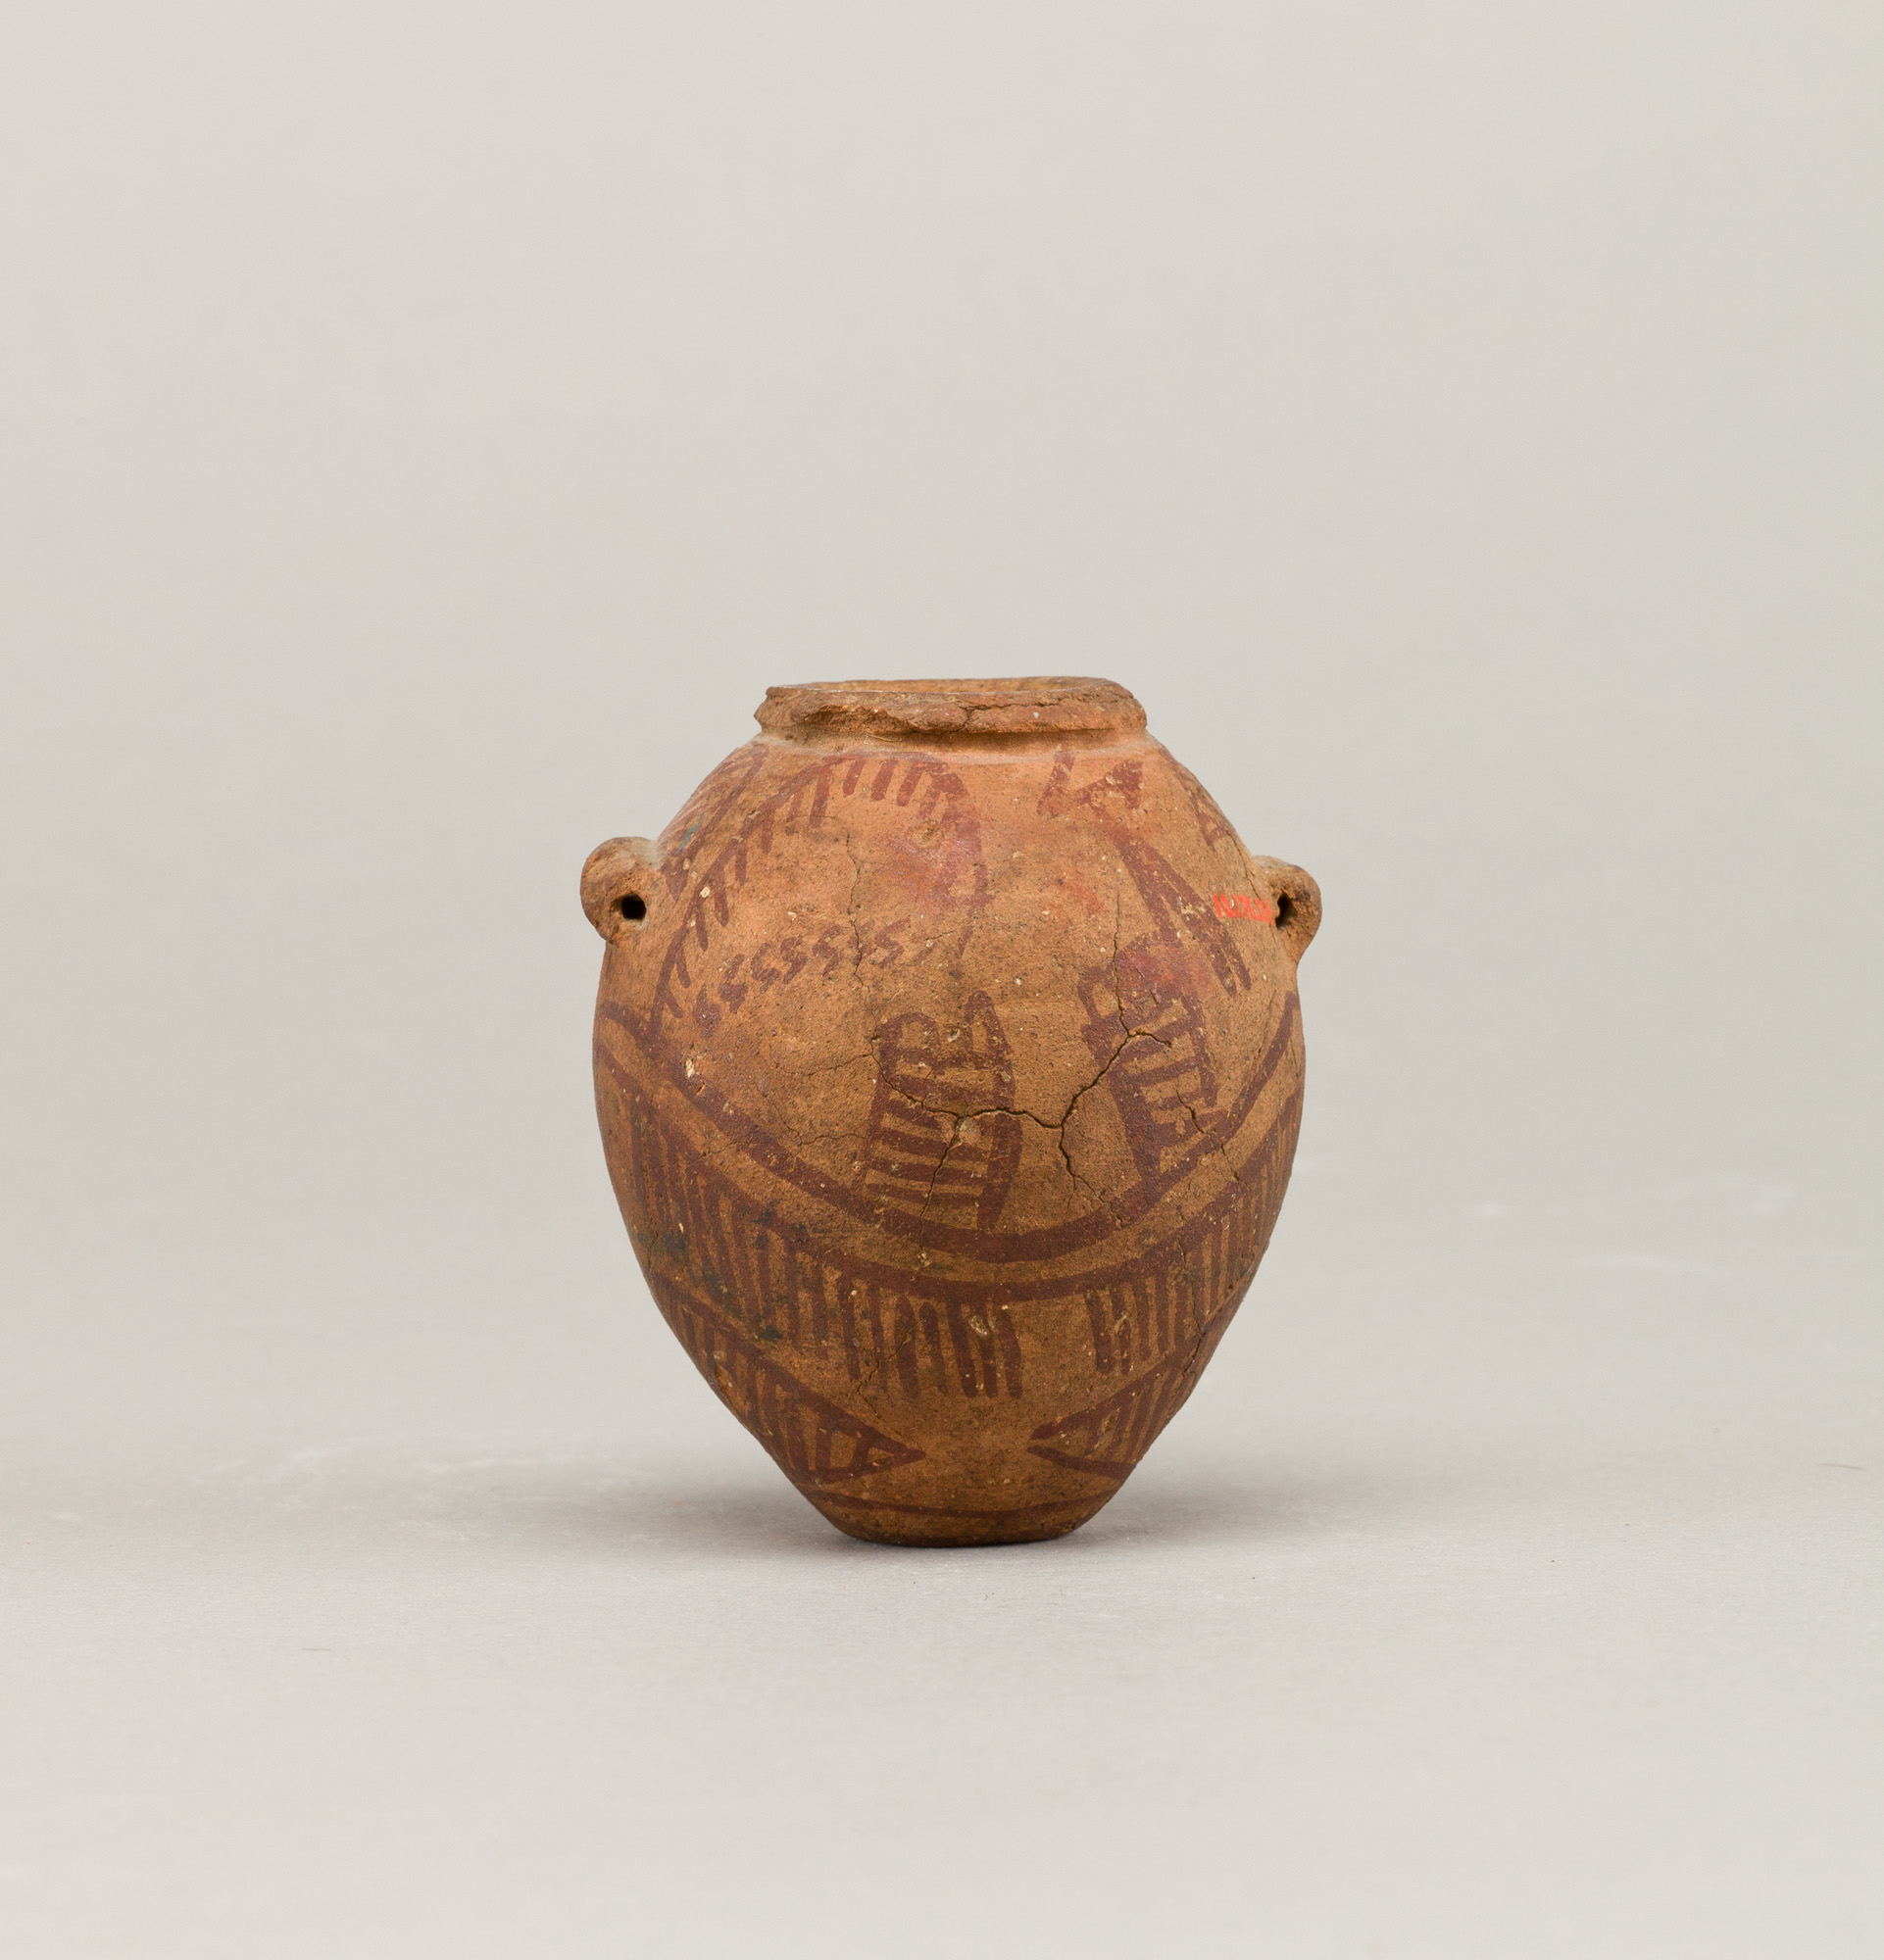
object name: jar, decorated ware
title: Decorated ware jar with two boats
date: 3650-3500 BCE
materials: paint, pottery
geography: egypt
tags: boats